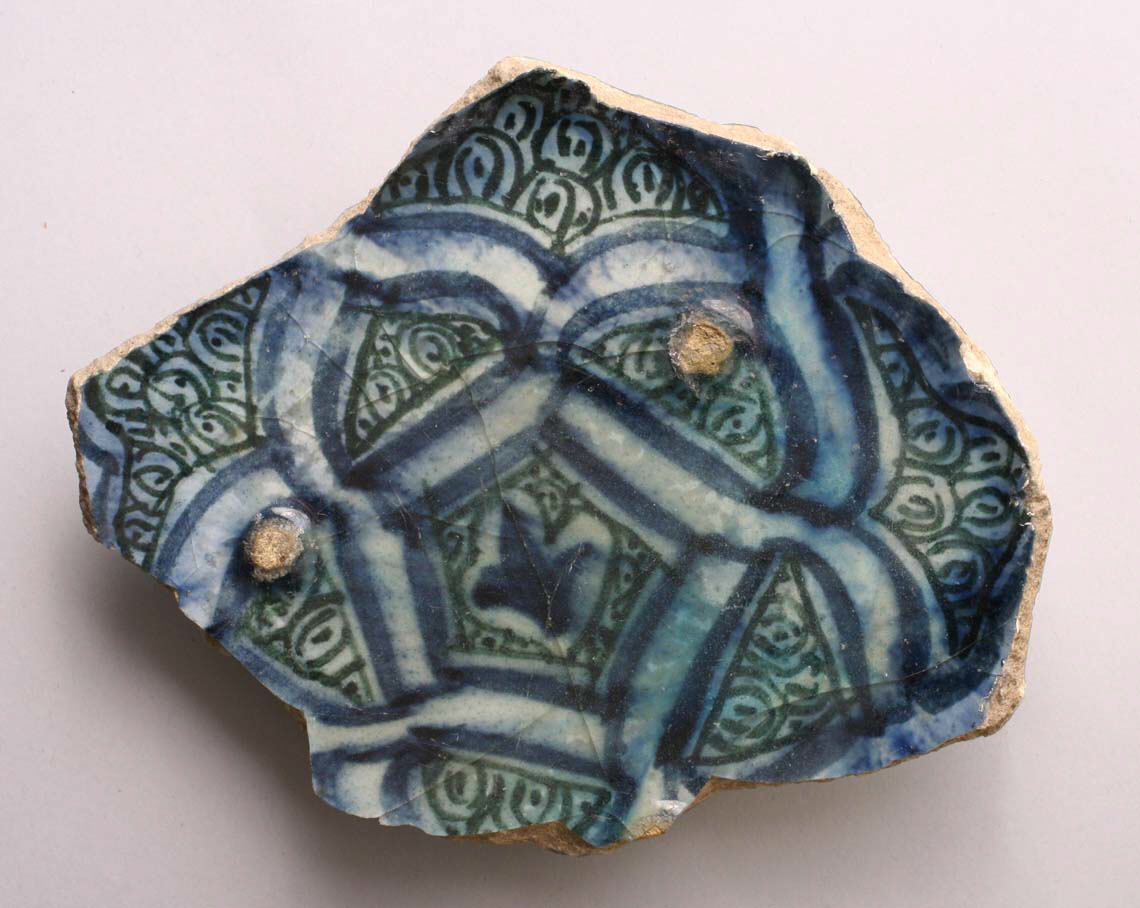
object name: fragment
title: Ceramic Fragment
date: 1301-1500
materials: glaze, stonepaste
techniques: painting, polychrome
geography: egypt